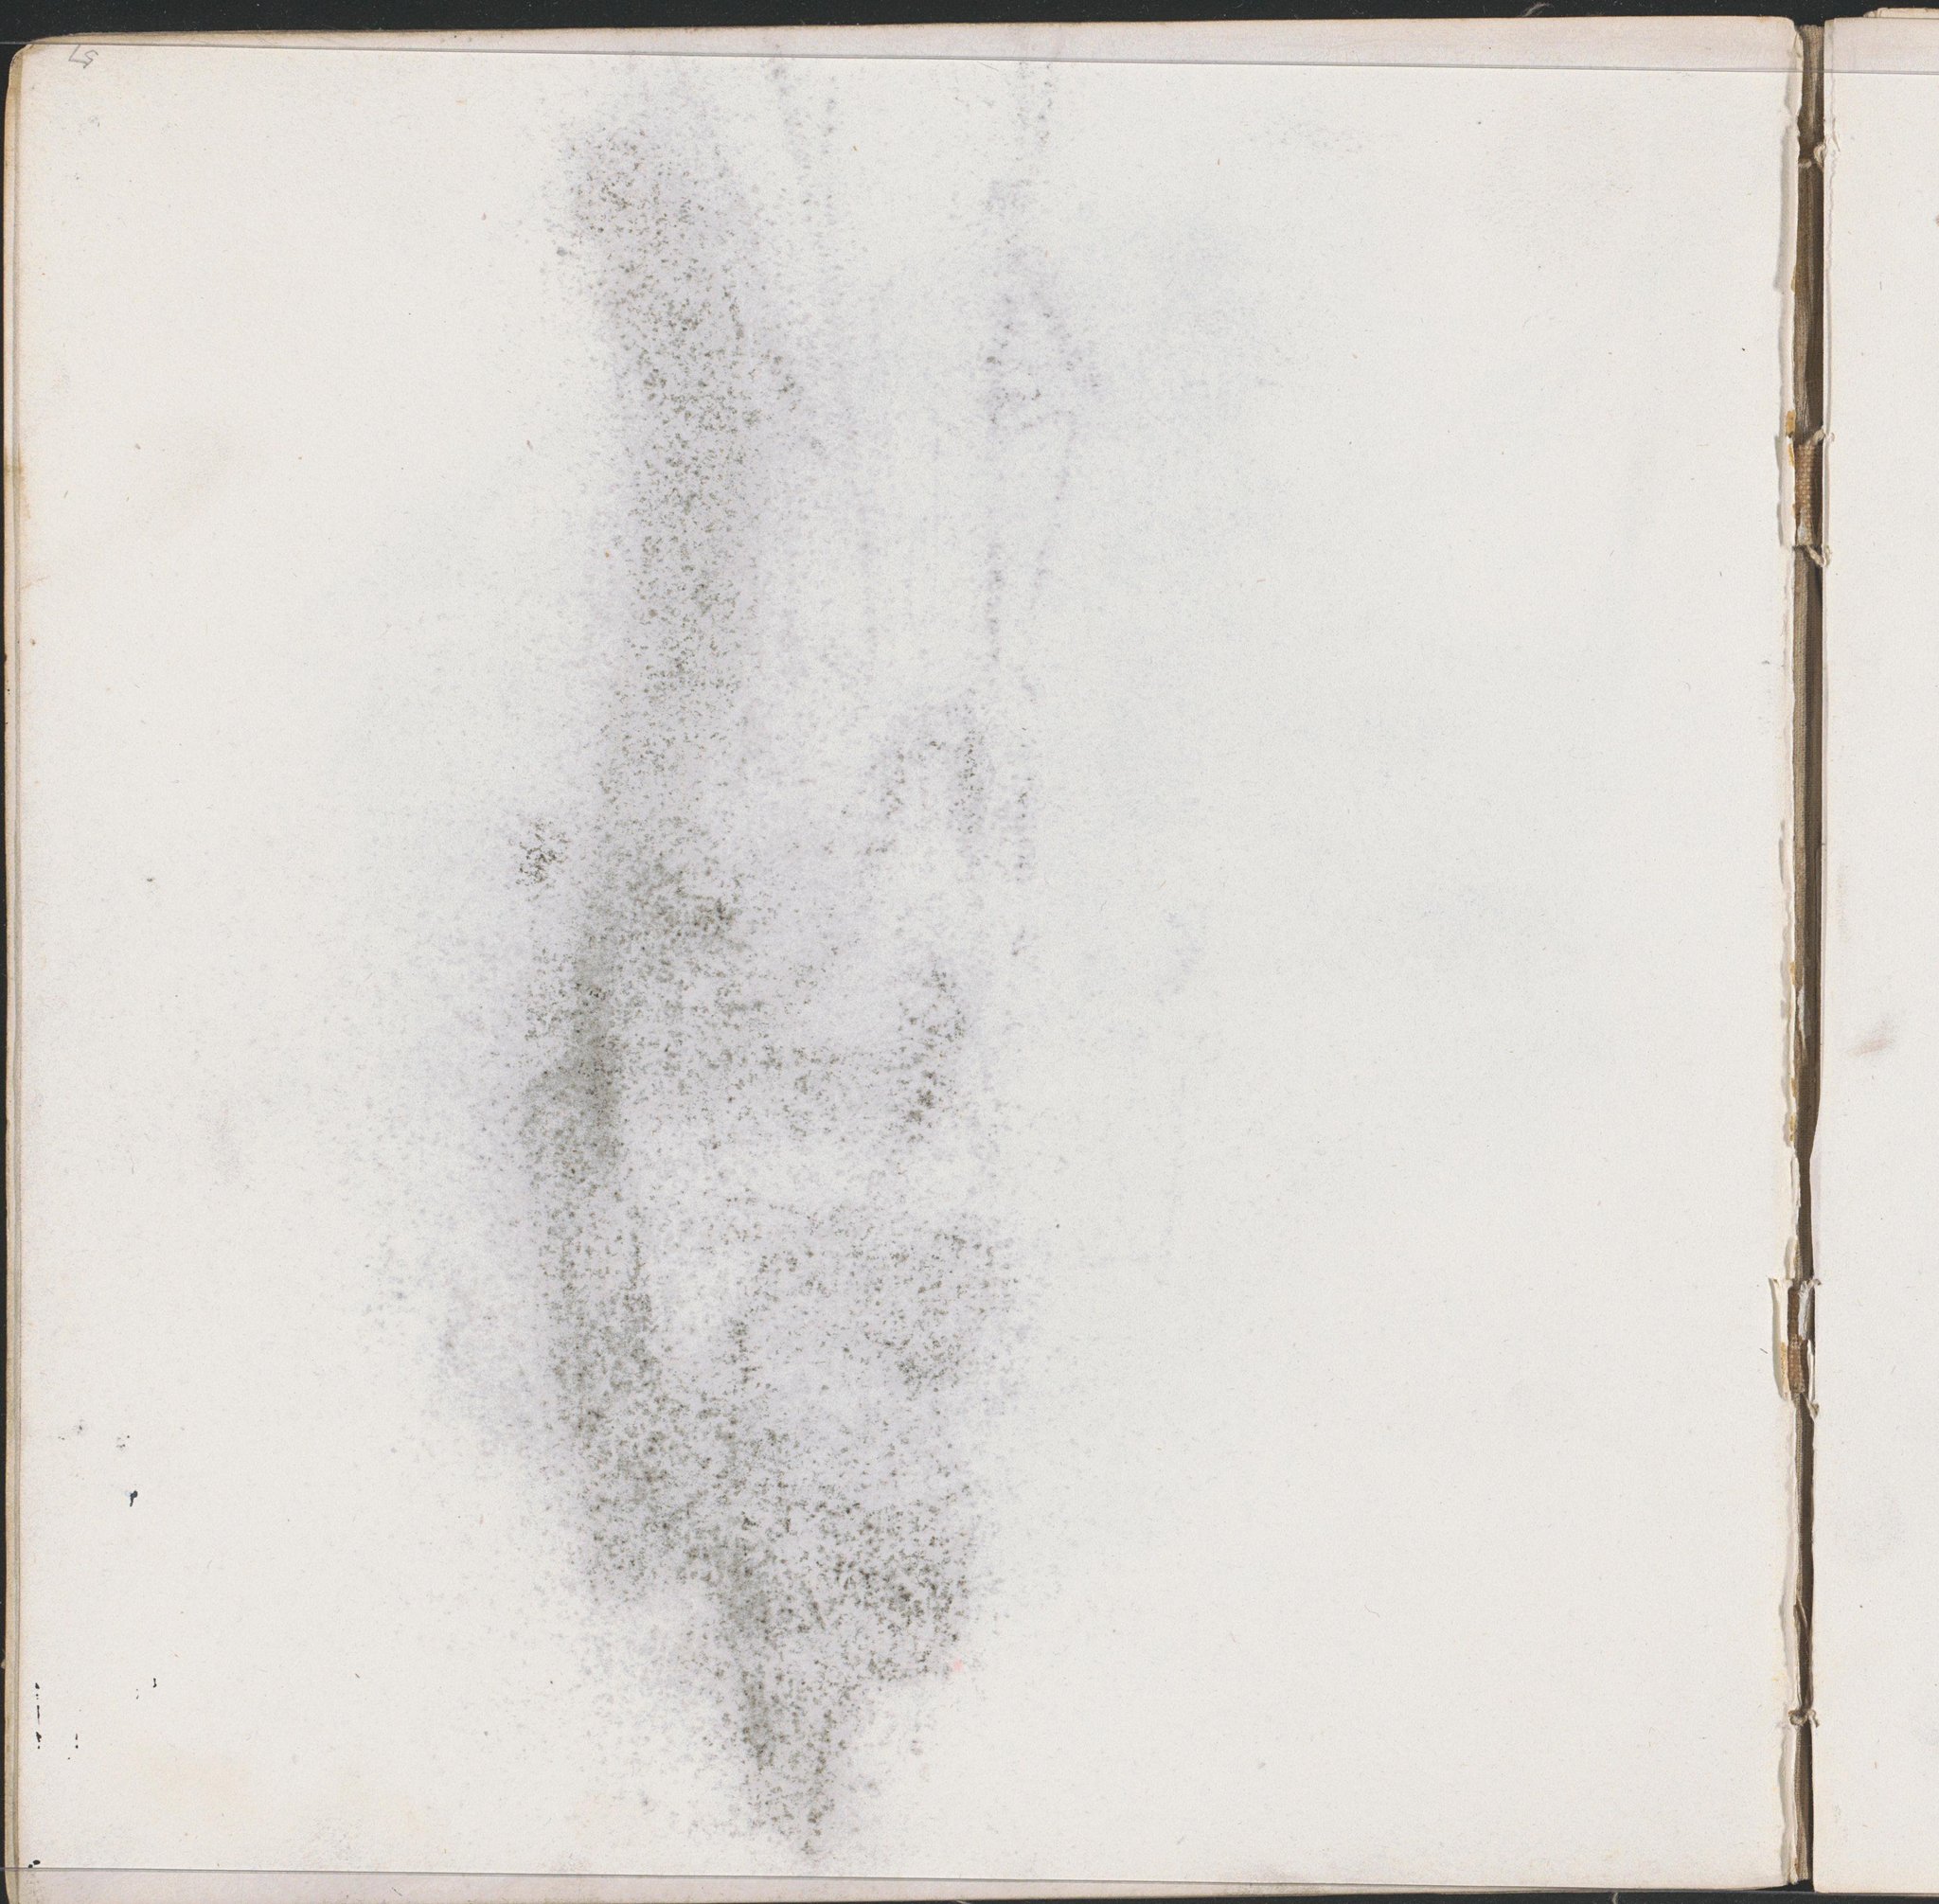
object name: sketchbook leaf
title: Abklatsch van een krijttekening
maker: isaac israels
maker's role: draughtsman, painter, print maker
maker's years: 1865-1934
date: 1875-1934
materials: paper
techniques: printmaking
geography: the hague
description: De originele tekening, mogelijk een figuurstudie, is niet meer aanwezig. Blad 6 verso uit schetsboek IX met 28 bladen.